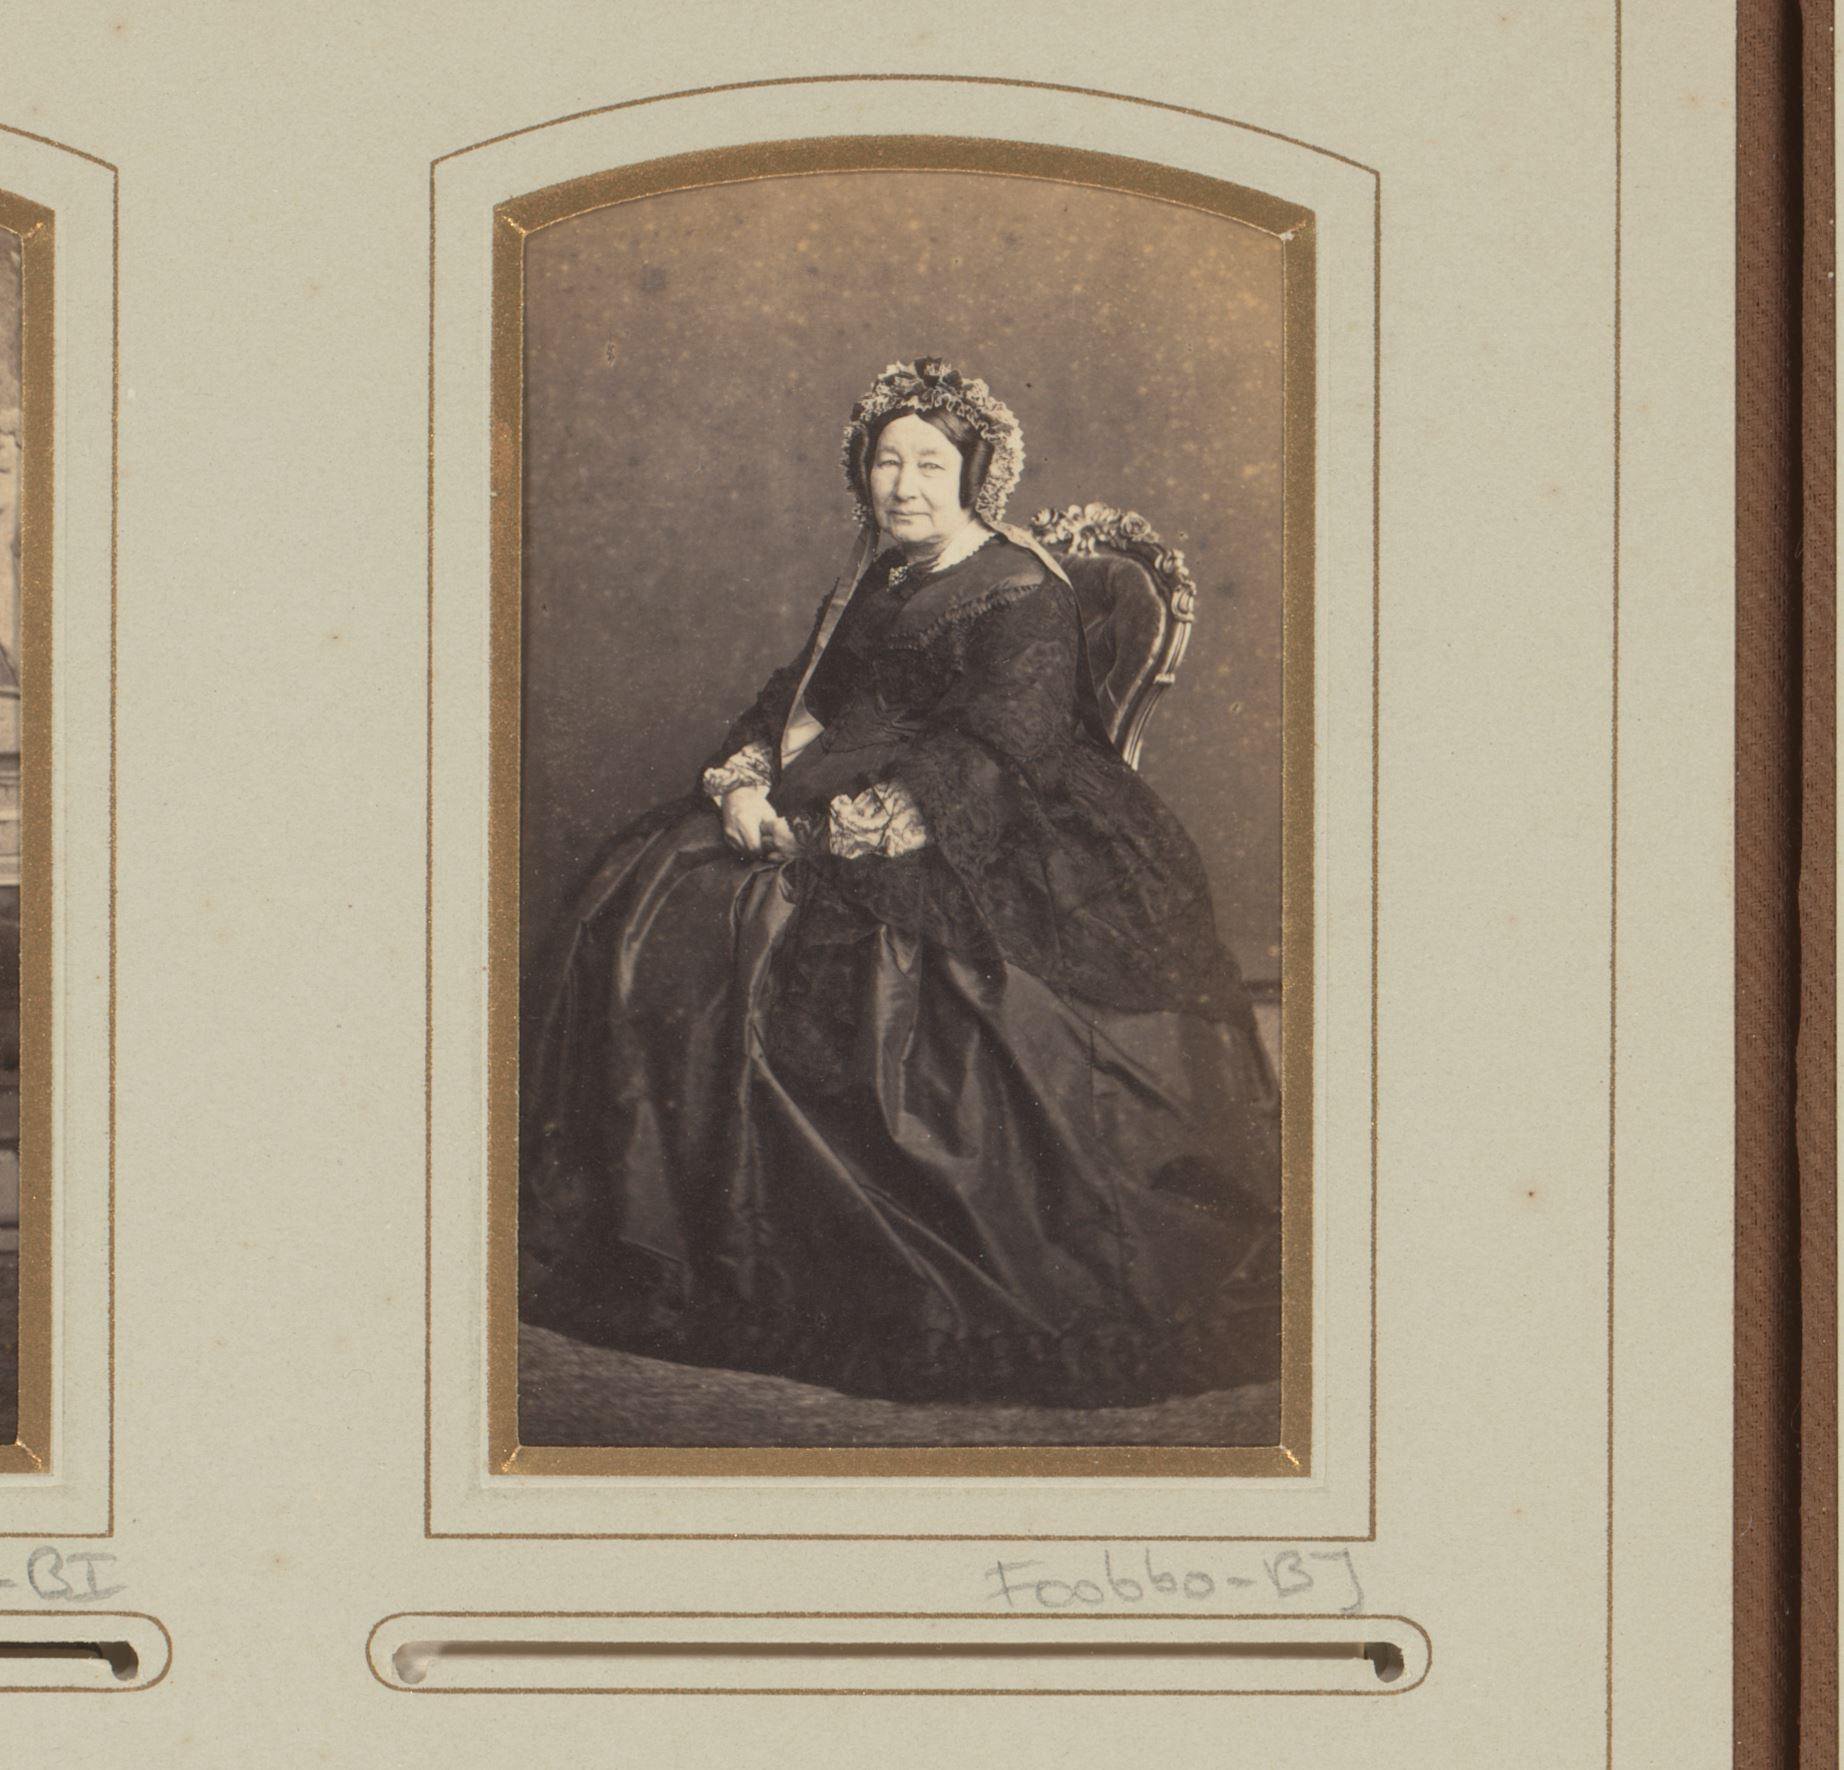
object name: album leaf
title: Portret van een zittende vrouw met hoofddeksel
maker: joseph dupont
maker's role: fotograaf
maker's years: 1818-1901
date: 1853-1880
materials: cardboard, photographic support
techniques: albumen print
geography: antwerp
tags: sitting figure - aa - female human figure, historical persons - bb - woman, head-gear: cap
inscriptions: inscription: ‘Etablissement Photographique/ DE/ J. DUPONT,/ Place de Meir, 32/ ANVERS./ Maison fondée en 1853.’